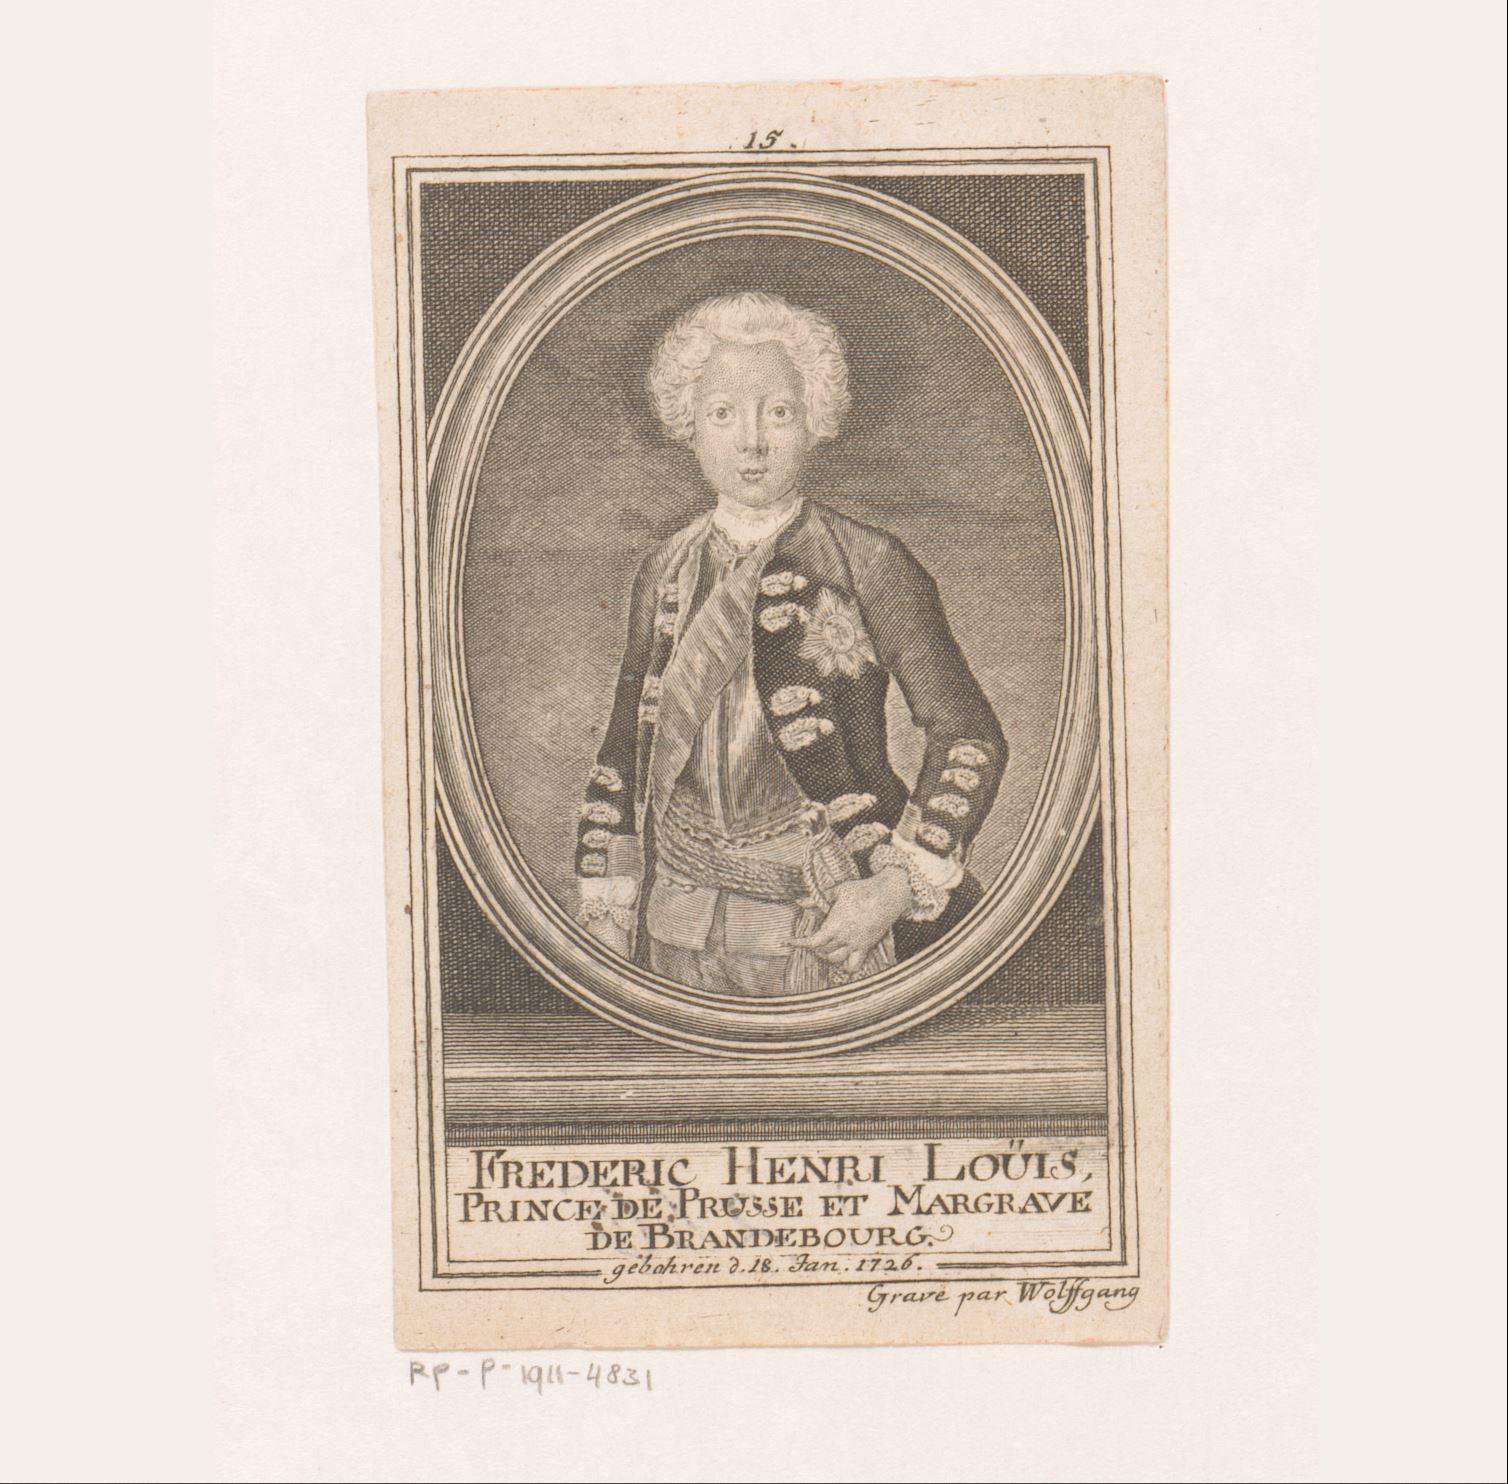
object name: print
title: Portret van Hendrik, prins van Pruisen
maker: gustav andreas wolfgang (1692-1775)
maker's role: print maker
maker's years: 1692-1775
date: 1740-1775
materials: paper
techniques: engraving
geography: germany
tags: berlin, friedrich heinrich ludwig van pruisen, historical persons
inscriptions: collector's mark: Lugt 2228, collector's mark: Lugt 358, number: ‘O. 286’